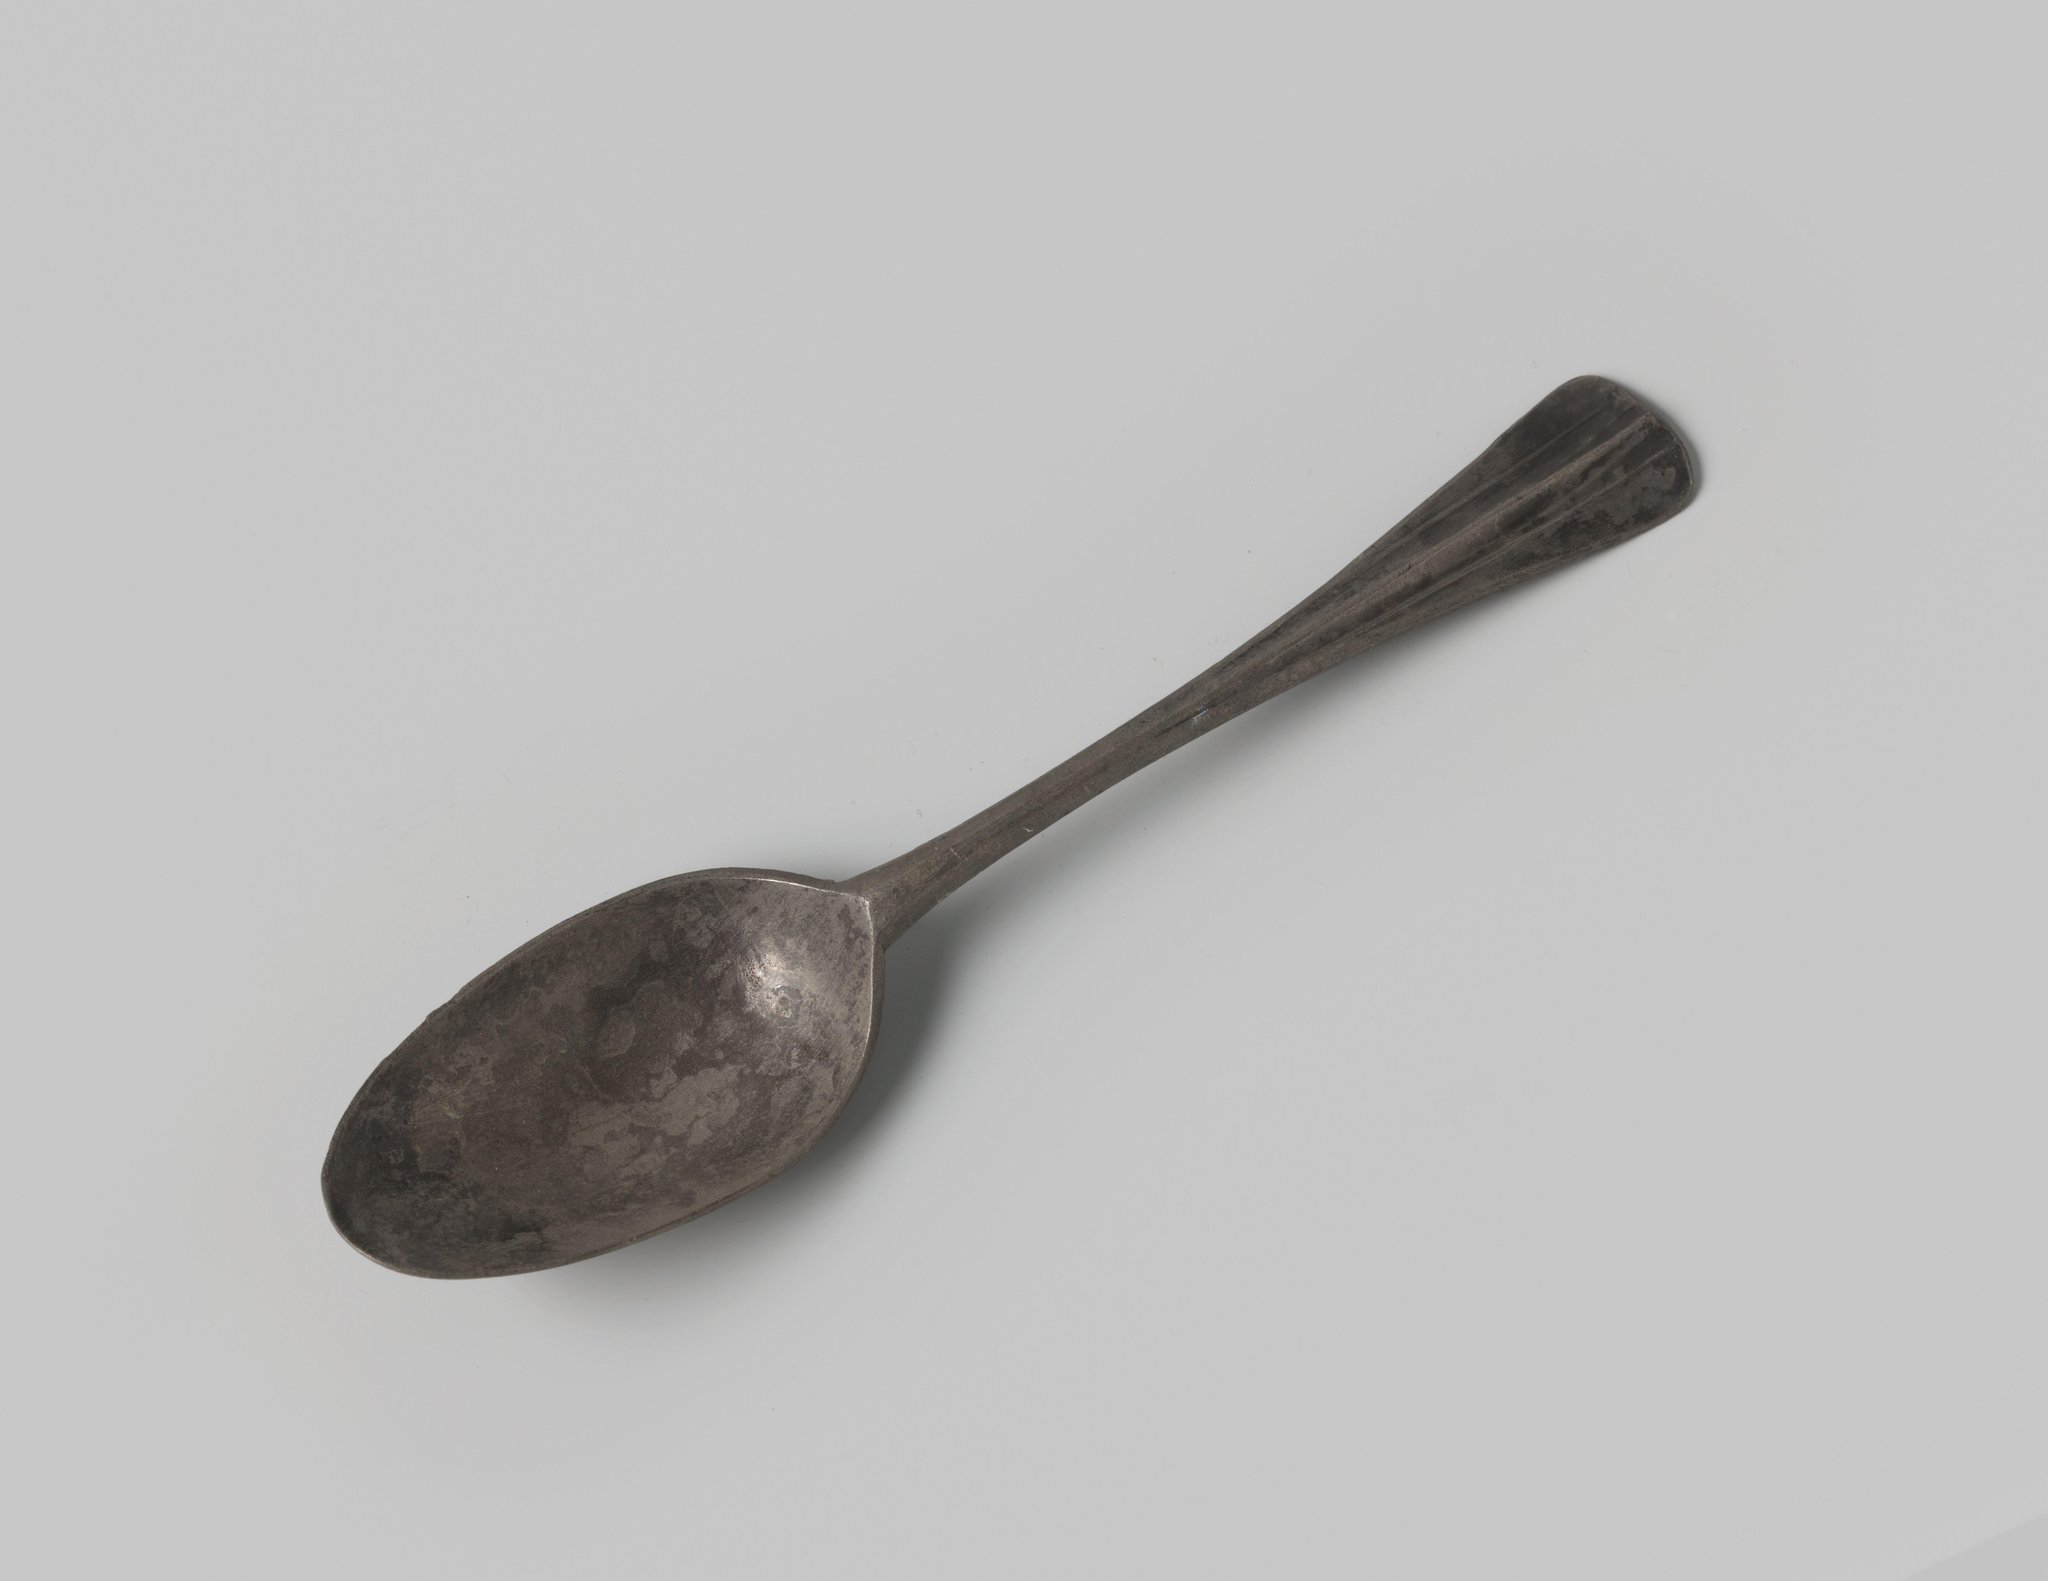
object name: spoon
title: Lepel uit het wrak van de in 1735 vergane Oost-Indiëvaarder 't Vliegend Hart, vervaardigd in Londen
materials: tin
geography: middelburg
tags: 't vliegend hart (schip), verenigde oostindische compagnie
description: Tinnen lepel. Spoon. Gemerkt X en LONDON.